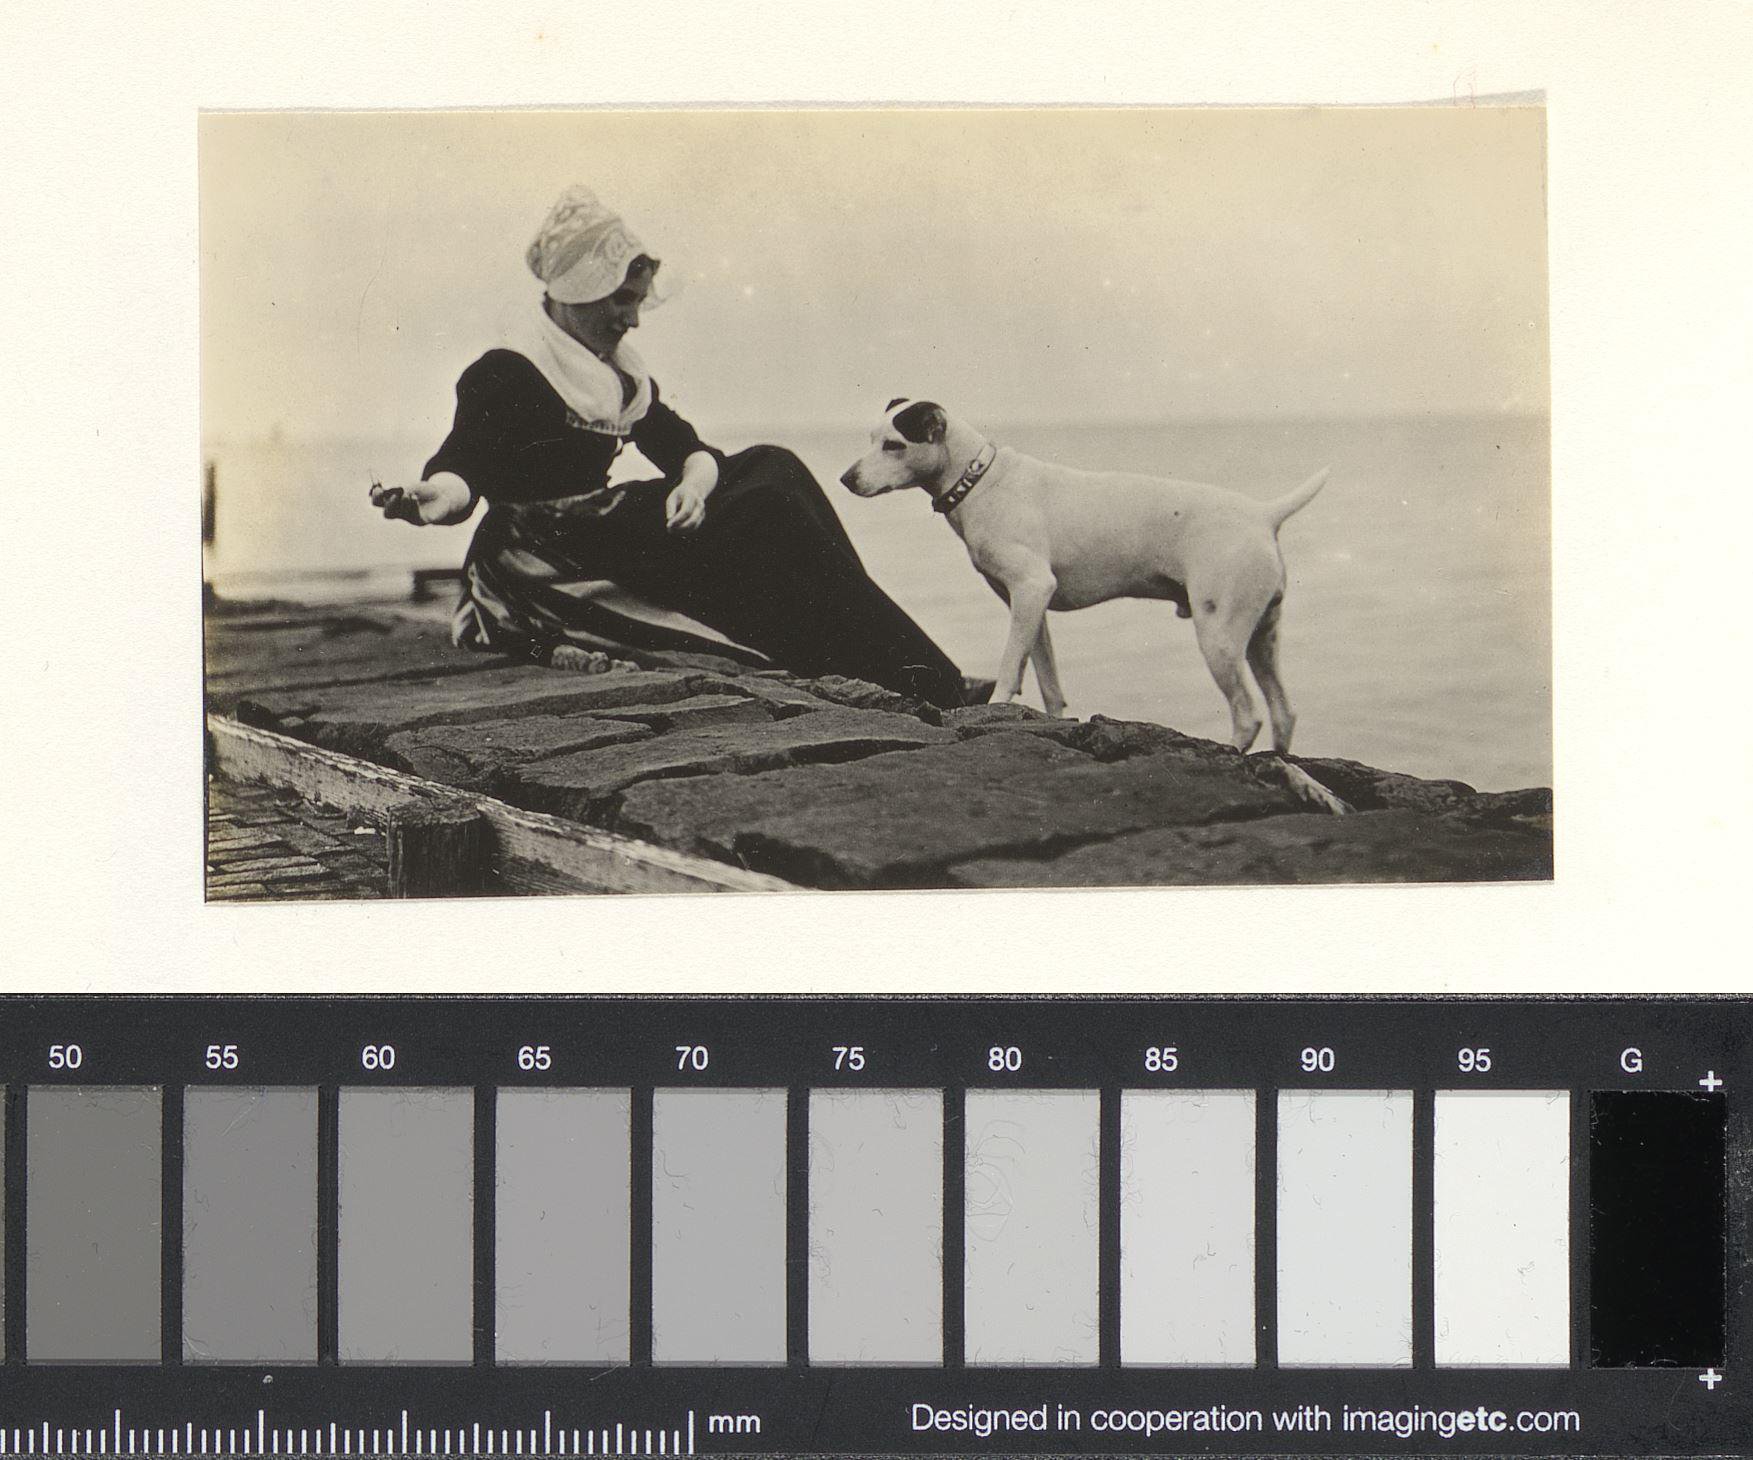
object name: photograph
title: Vrouw in klederdracht met een hond aan een water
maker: george hidderley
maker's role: fotograaf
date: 1900-1910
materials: paper, photographic support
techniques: gelatin silver print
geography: volendam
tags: adult woman, historical persons, landscapes with waters, waterscapes, seascapes (in the temperate zone), folk costume, regional costume, dog